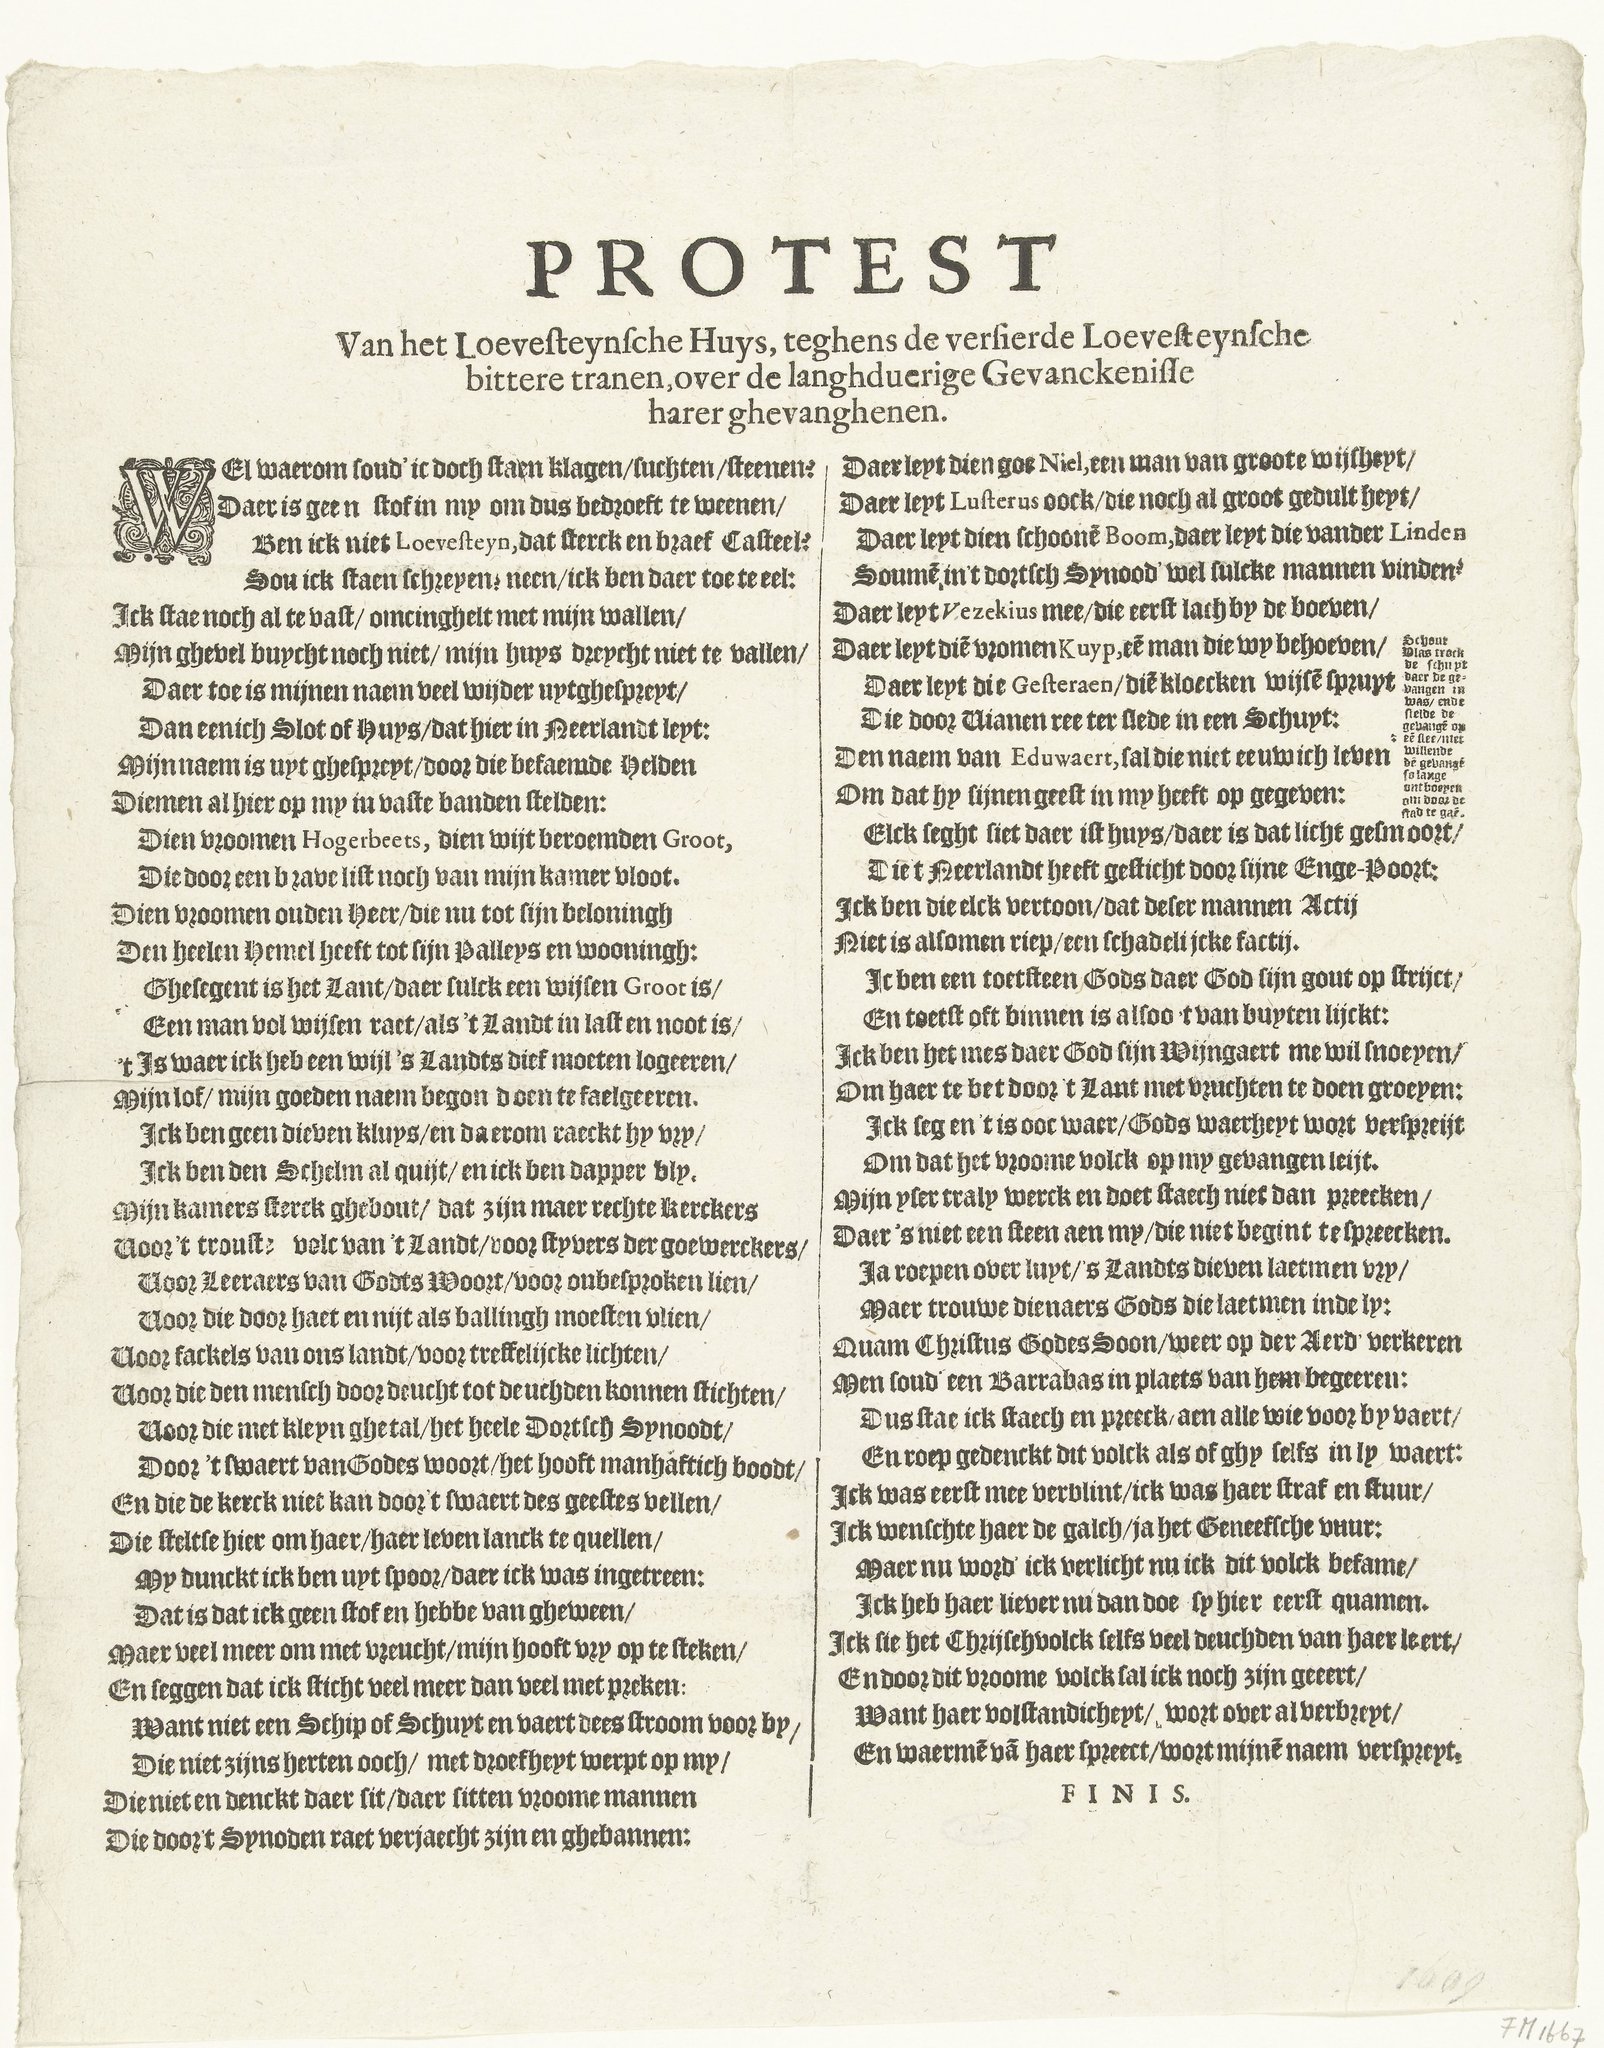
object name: poem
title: Protest Van het Loevesteynsche Huys, teghens de versierde Loevesteynsche bittere tranen, over de langhduerige Gevanckenisse harer ghevanghenen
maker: Anonymous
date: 1630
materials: paper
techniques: letterpress printing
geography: northern netherlands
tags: loevestein castle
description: Gedicht tegen langdurige opsluiting van de Remonstrantse gevangenen in slot Loevestein, in de vorm van een protest, 1630. Gedicht in 2 kolommen.